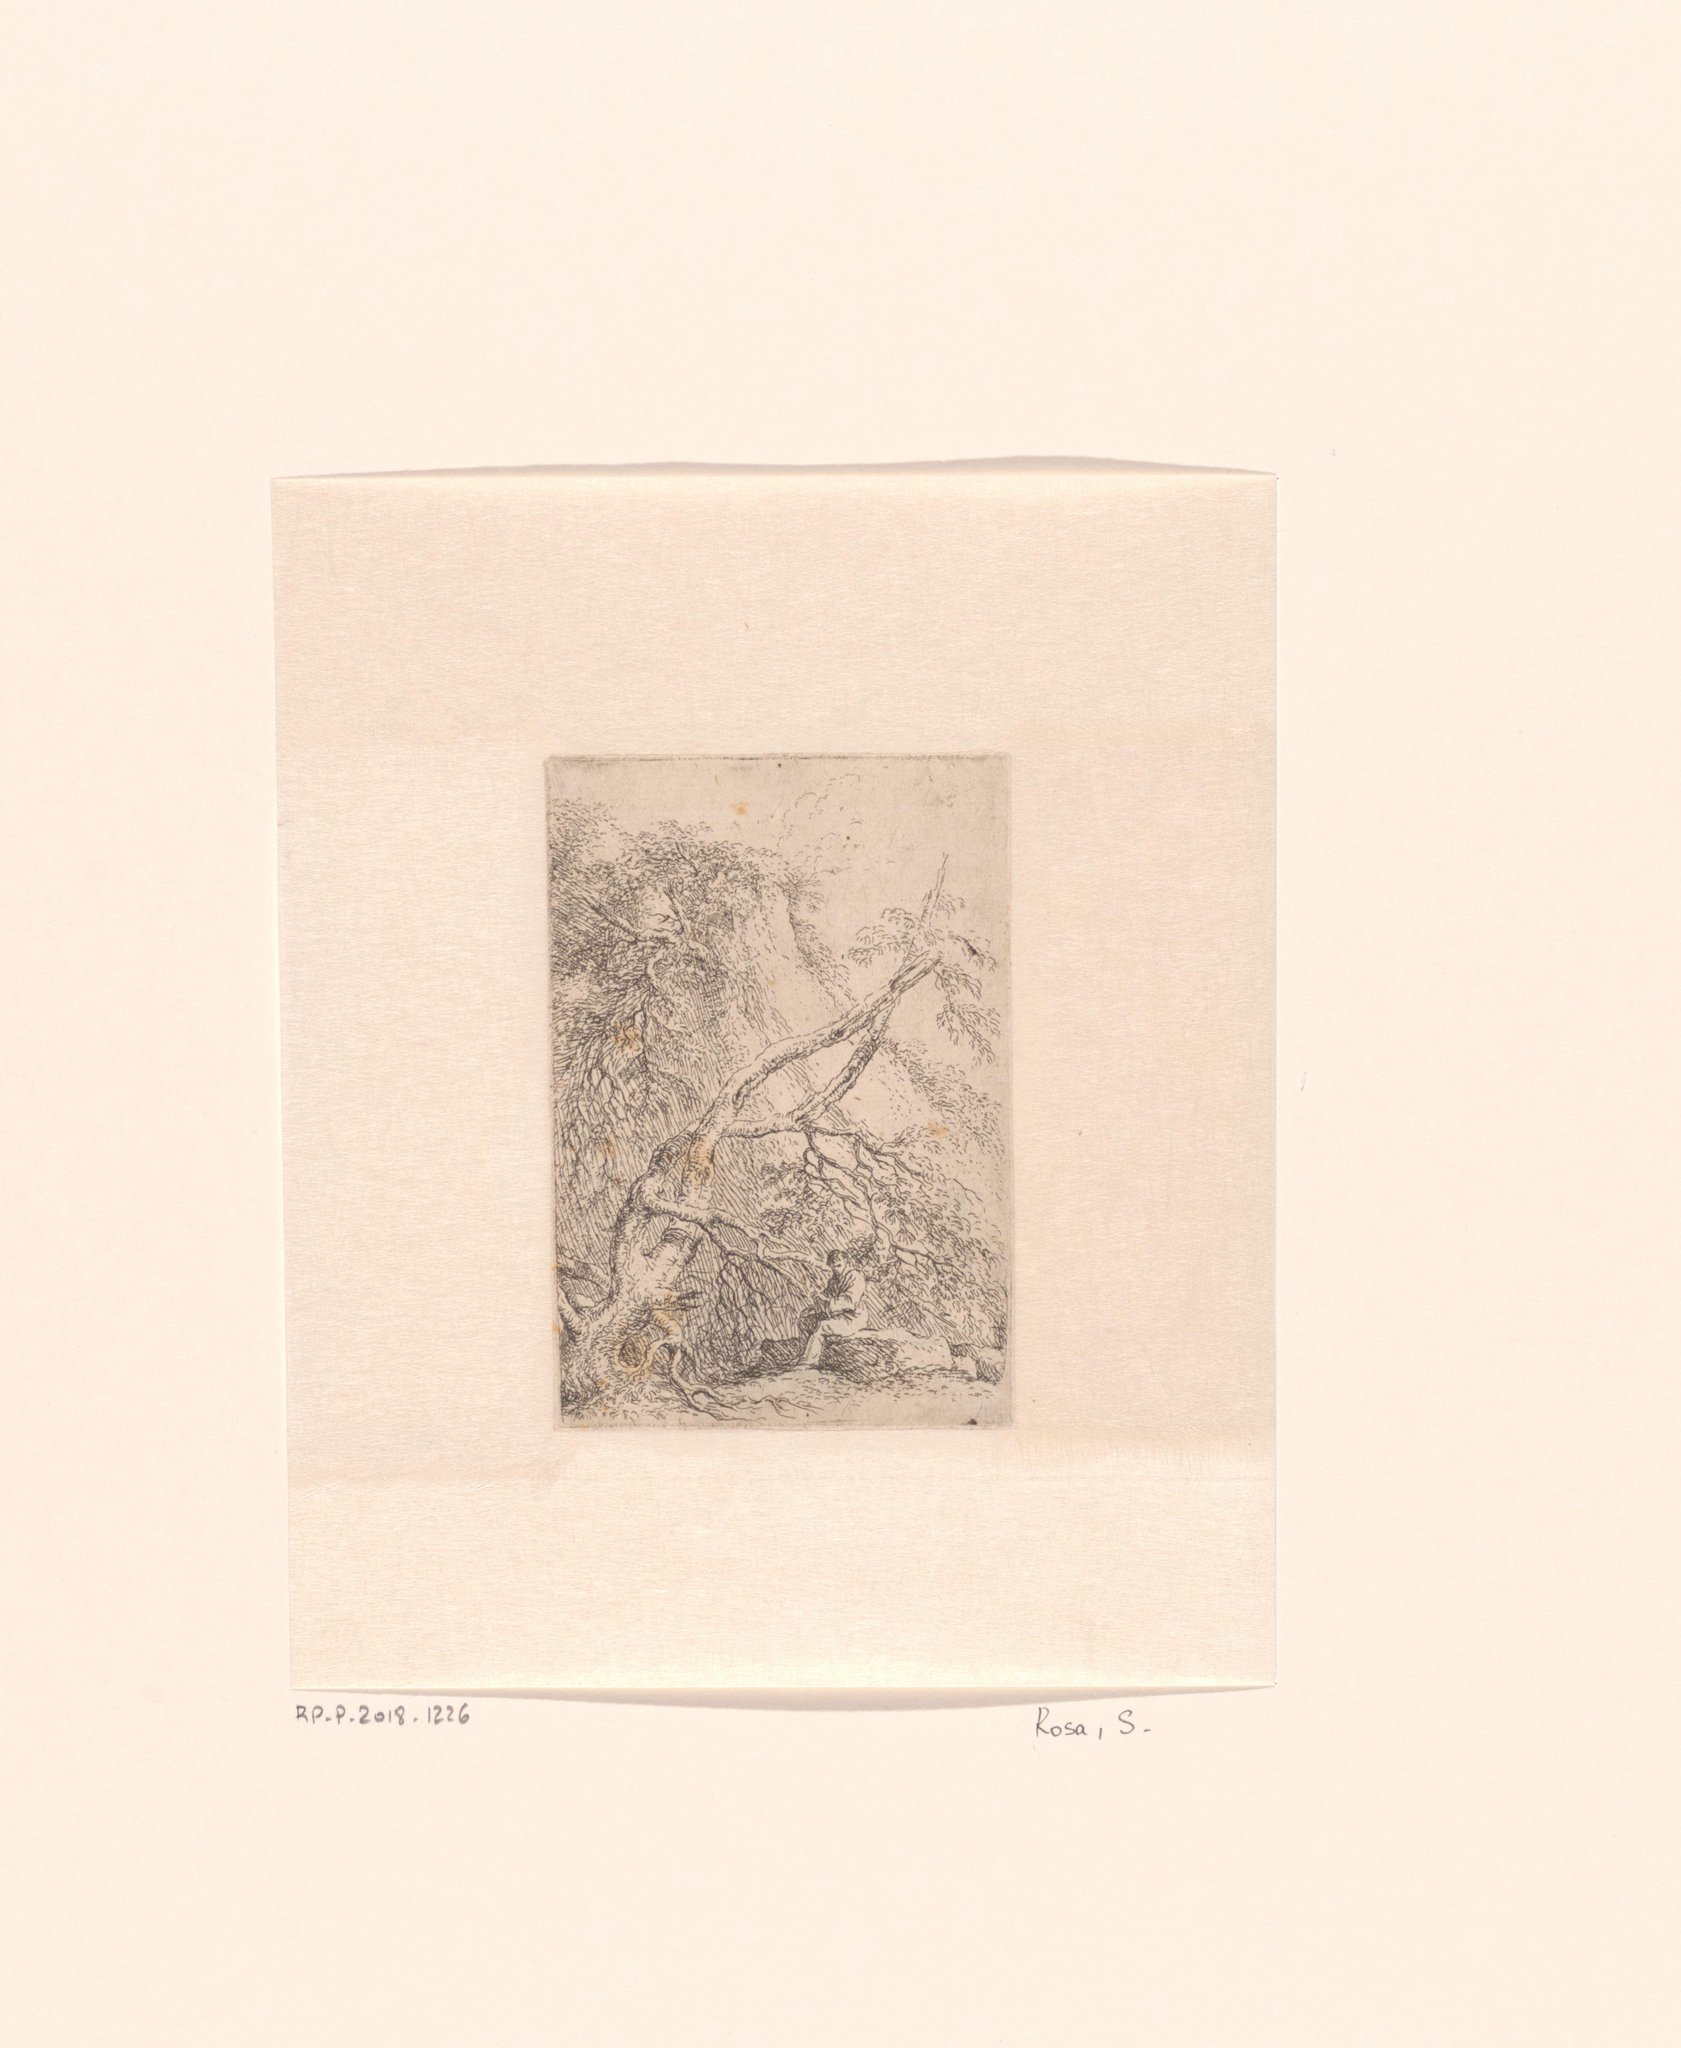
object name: print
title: Landschap met lezende monnik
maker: salvator rosa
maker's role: draughtsman, painter, print maker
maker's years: 1615-1673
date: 1640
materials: paper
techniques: etching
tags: trees, anchorite, hermit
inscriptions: collector's mark: Lugt 5k, collector's mark: Lugt 2228, collector's mark: Lugt 2760, collector's mark: Lugt 3869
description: Onder een rots en een oude boom zit een klein weergegeven monnik of kluizenaar met een boek in zijn hand.